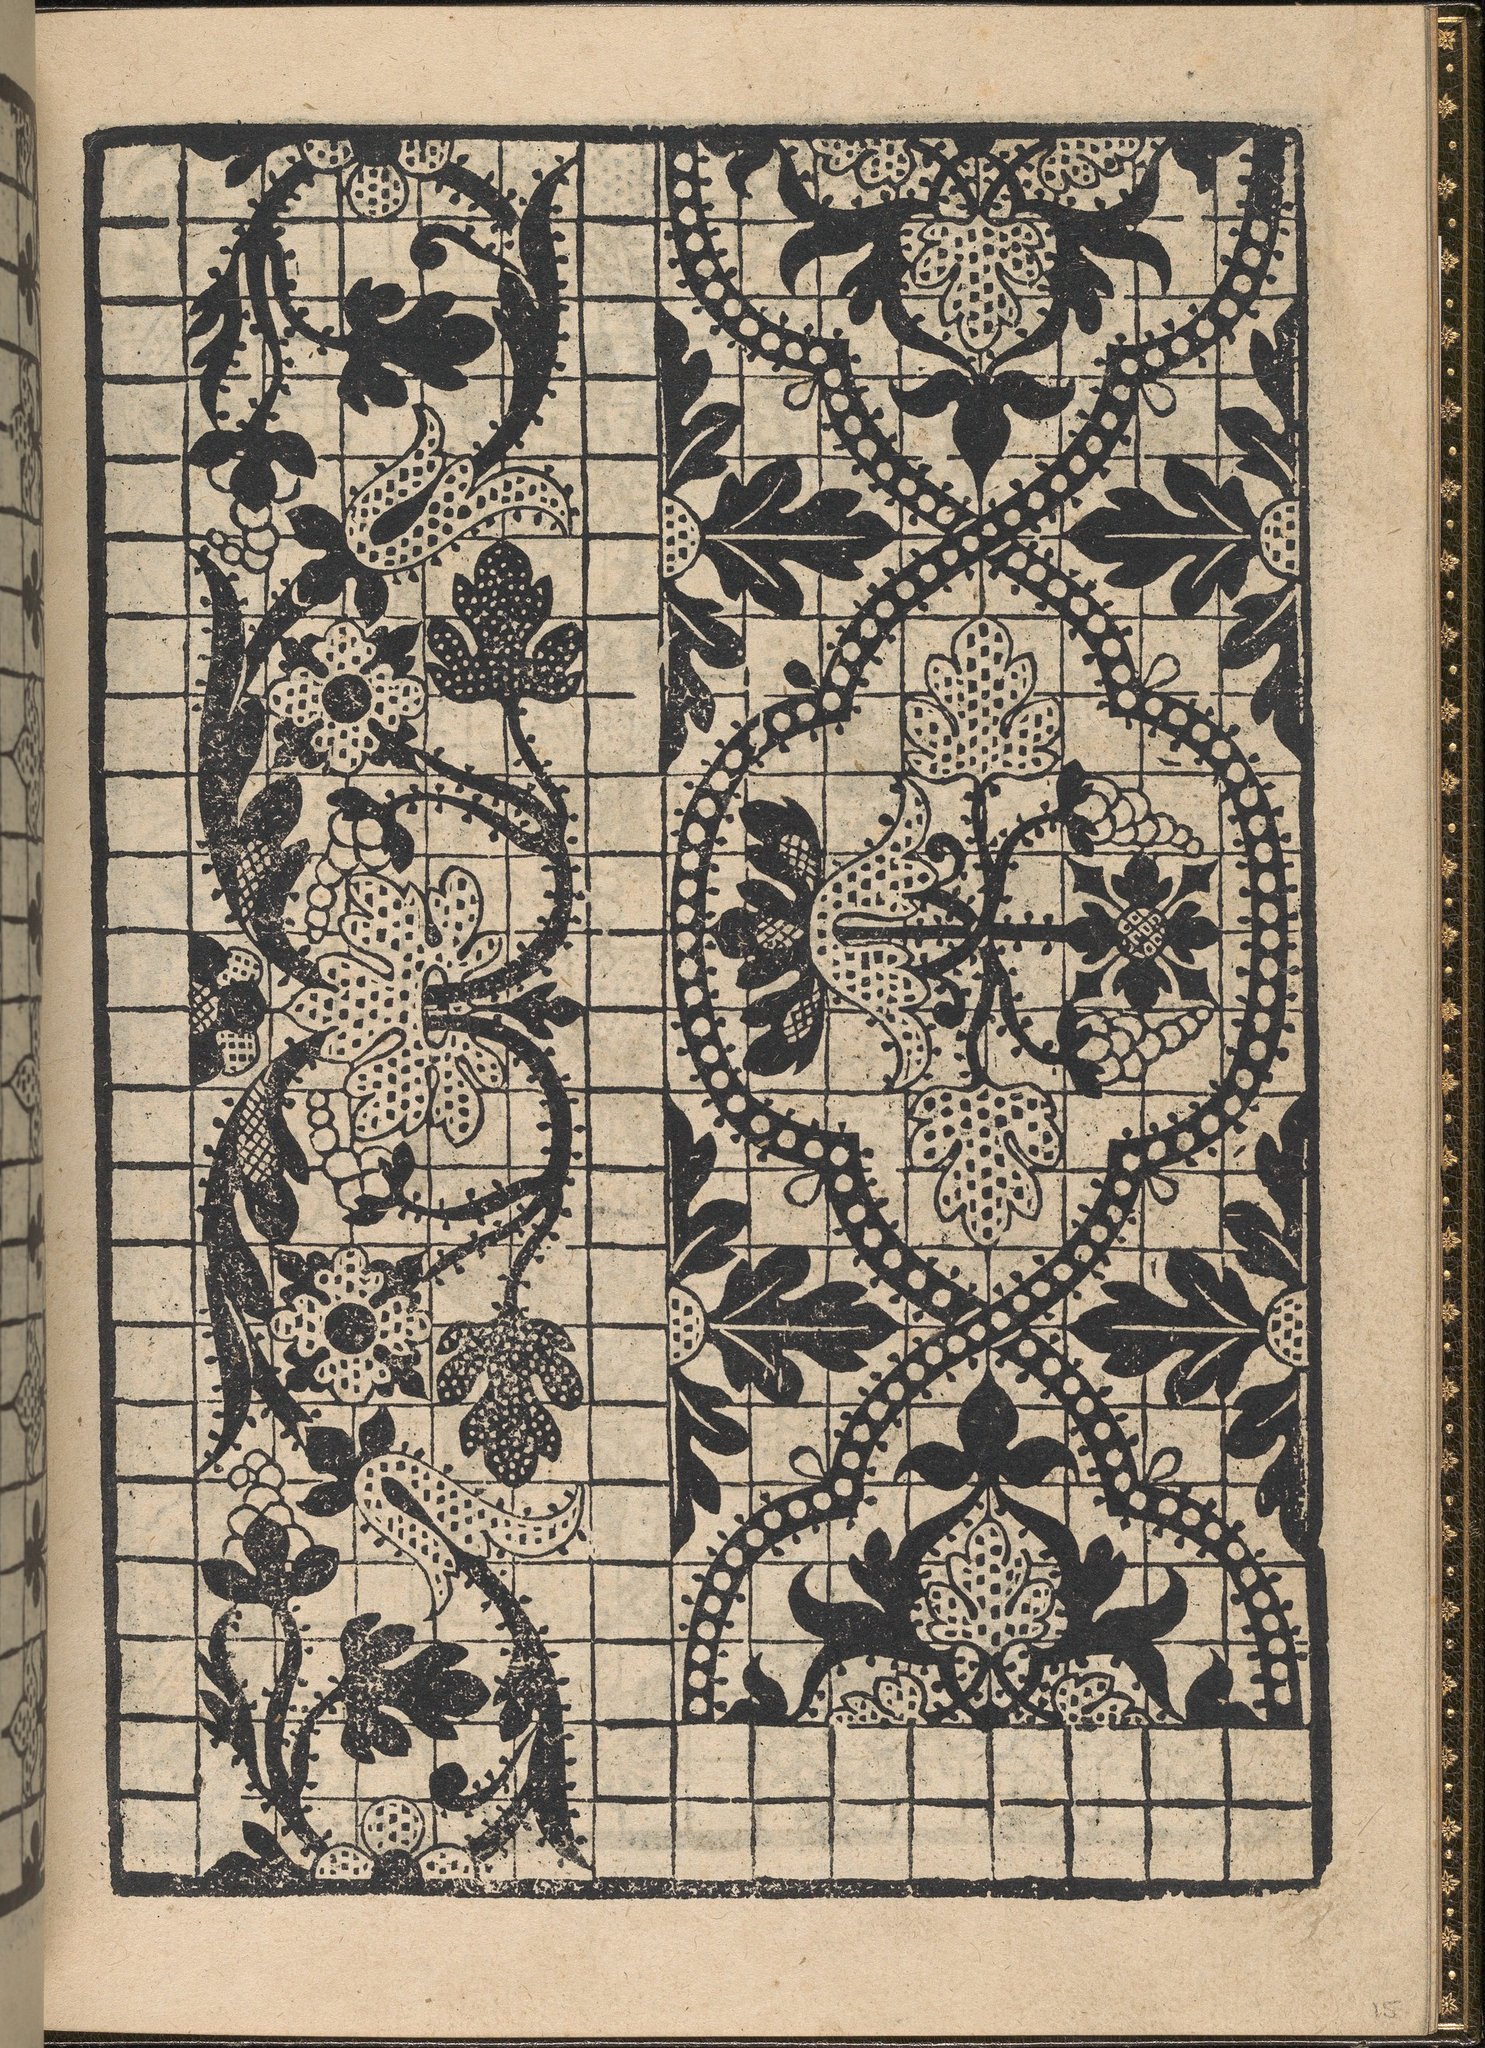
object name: book print ornament architecture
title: La Gloria et l'Honore di Ponti Tagliati, E Ponti in Aere, page 5 (verso)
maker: matteo pagano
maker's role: publisher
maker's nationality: italian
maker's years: 1515-1588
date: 1556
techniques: woodcut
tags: birds,flowers,vines